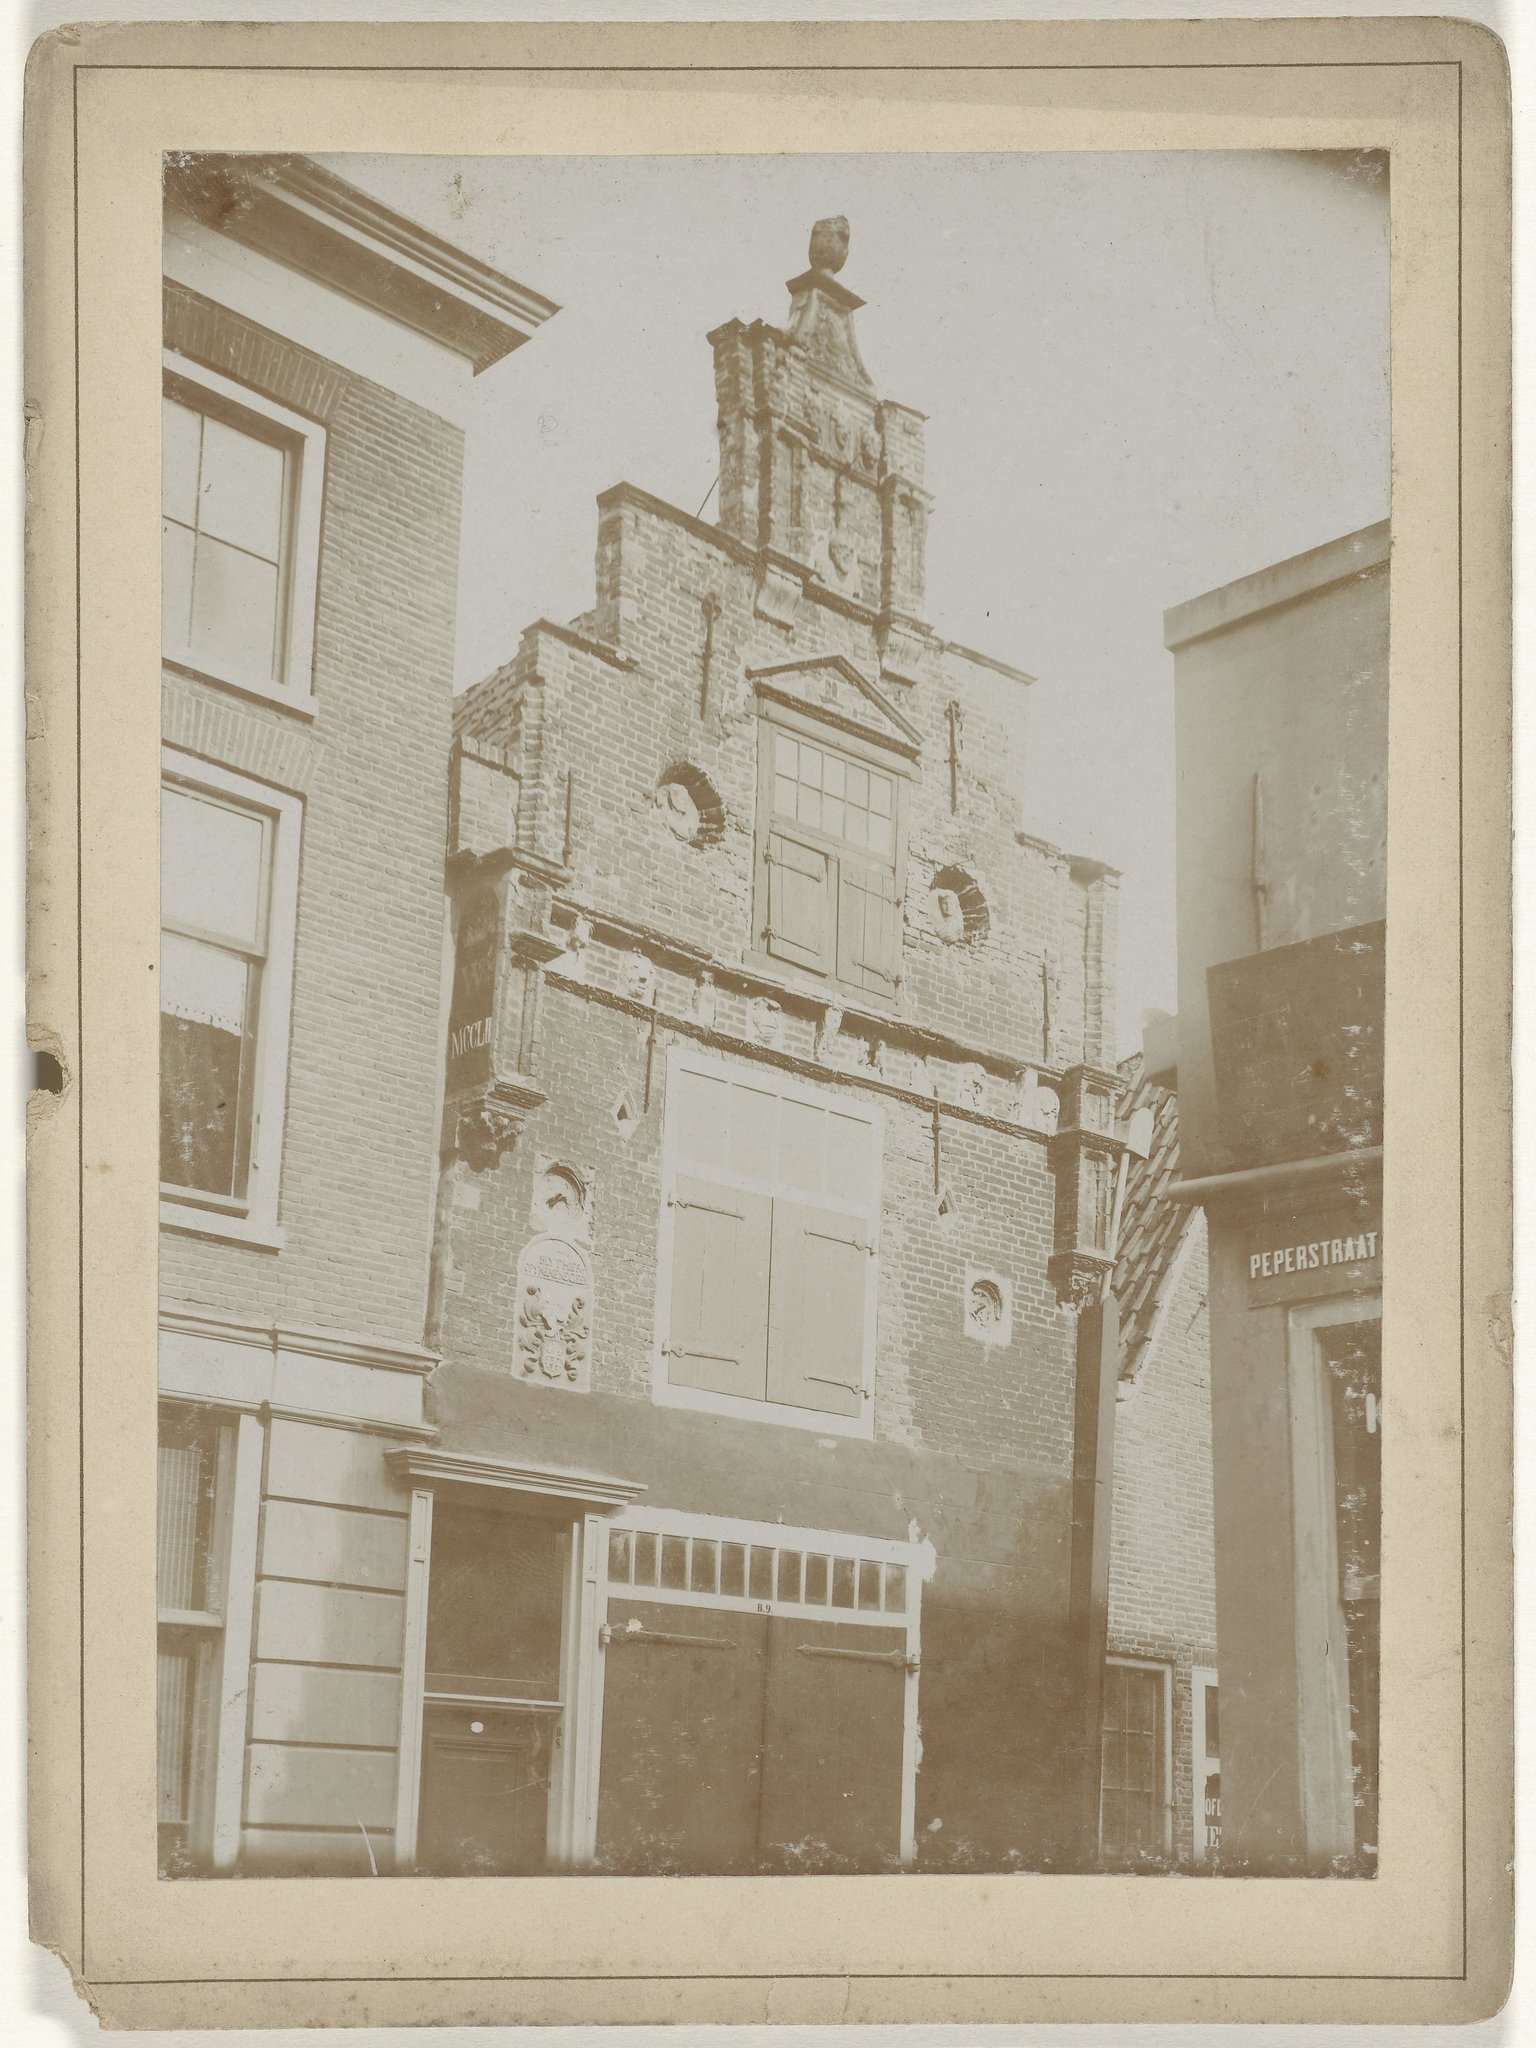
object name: cabinet photograph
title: Amsterdam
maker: Anonymous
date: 1880-1910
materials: paper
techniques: collodion silver print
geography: amsterdam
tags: urban housing